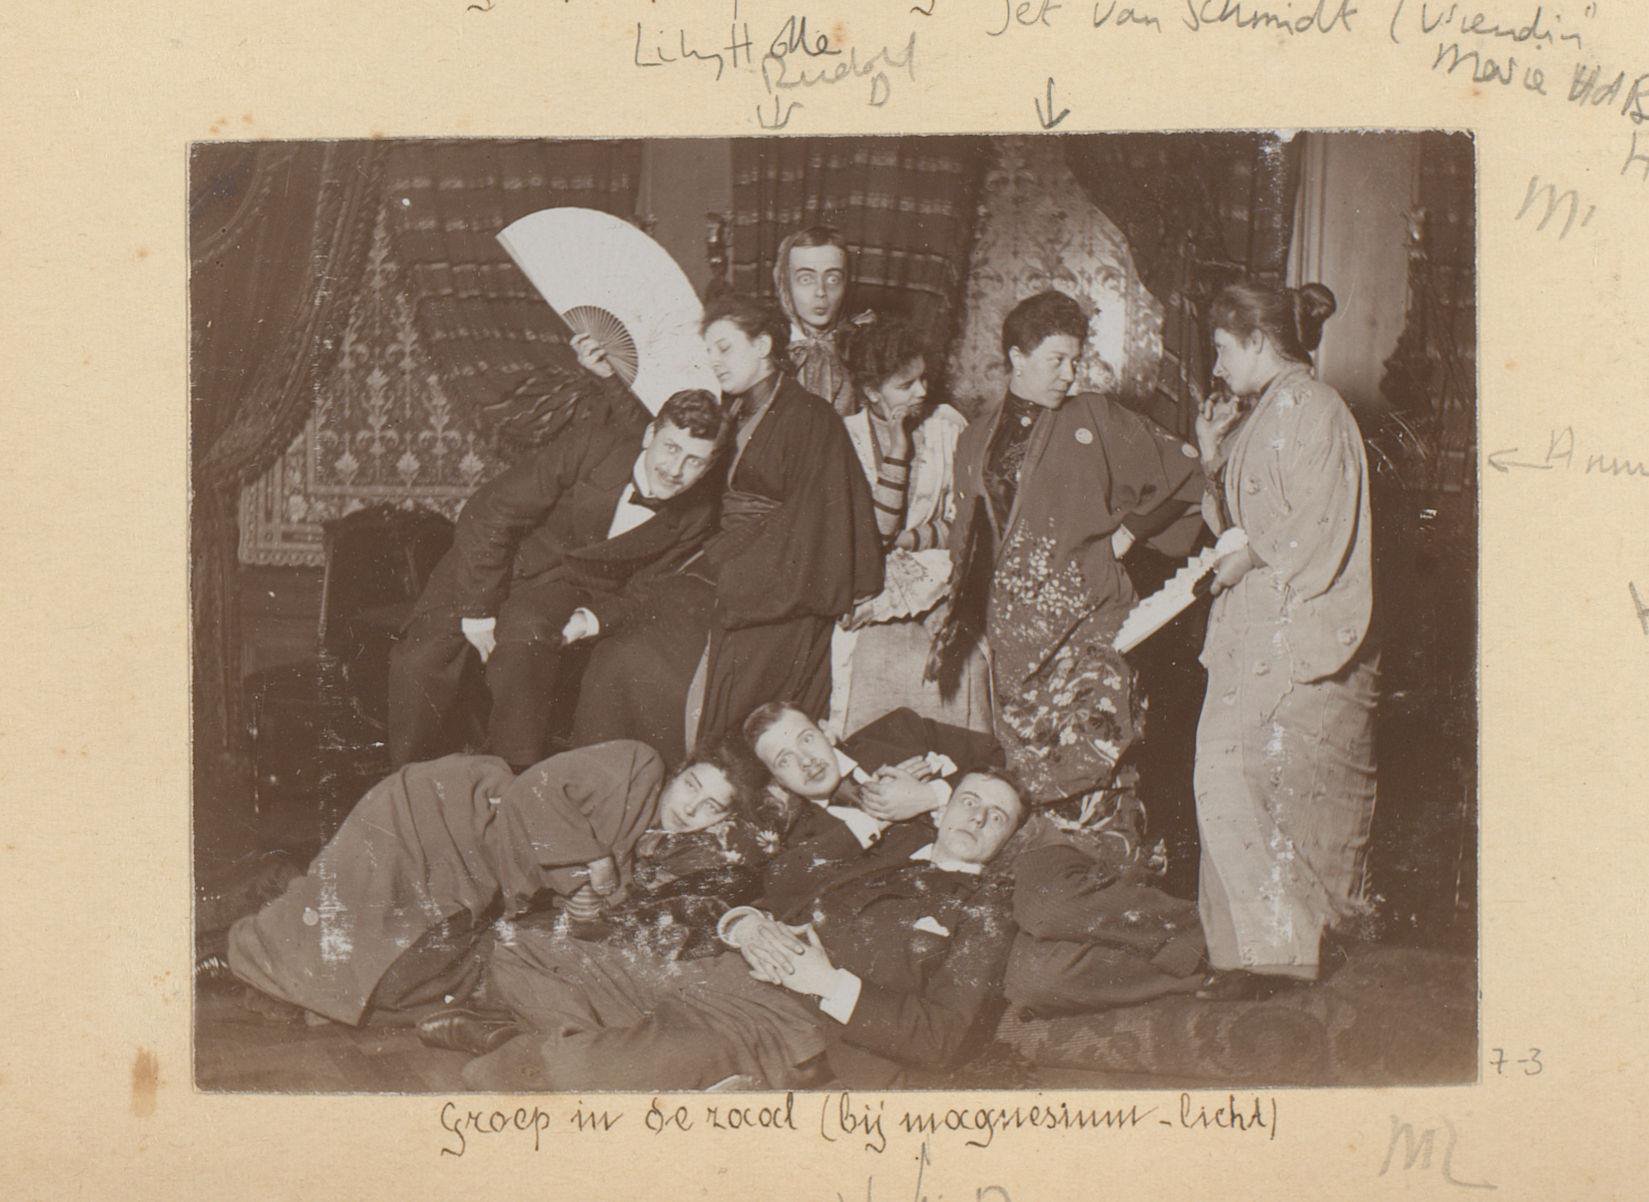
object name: photograph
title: Groepsportret van een gezelschap in historische kostuums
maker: hendrik herman van den berg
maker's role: amateurfotograaf, jurist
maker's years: 1875-1944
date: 1890-1894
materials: paper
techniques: collodion silver print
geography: amsterdam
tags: haarlem, batavia, historical persons, historical costume, amsterdam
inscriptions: caption: ‘[...]/ Jet van Schmidt (vriendin Marie van [...] Hoogeveen)/ Annie’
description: De foto is gemaakt bij flitslicht afkomstig van bliksempoeder.